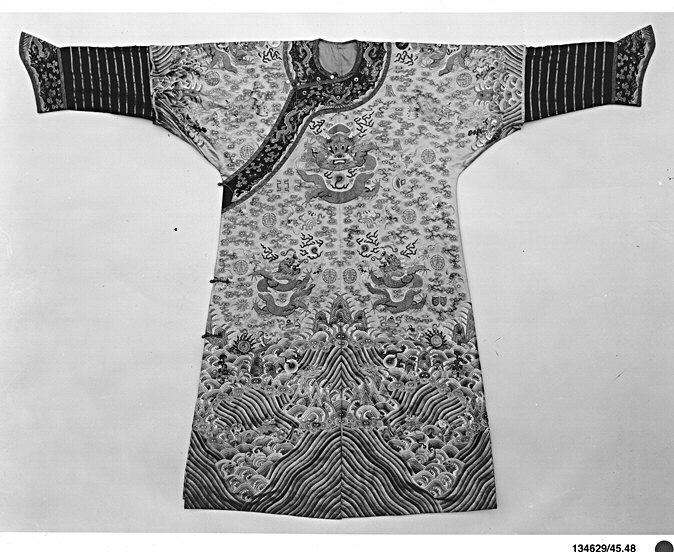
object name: robe, emperor's 12 symbol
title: Emperor's Twelve-Symbol robe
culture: chinese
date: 1835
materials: silk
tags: dragons